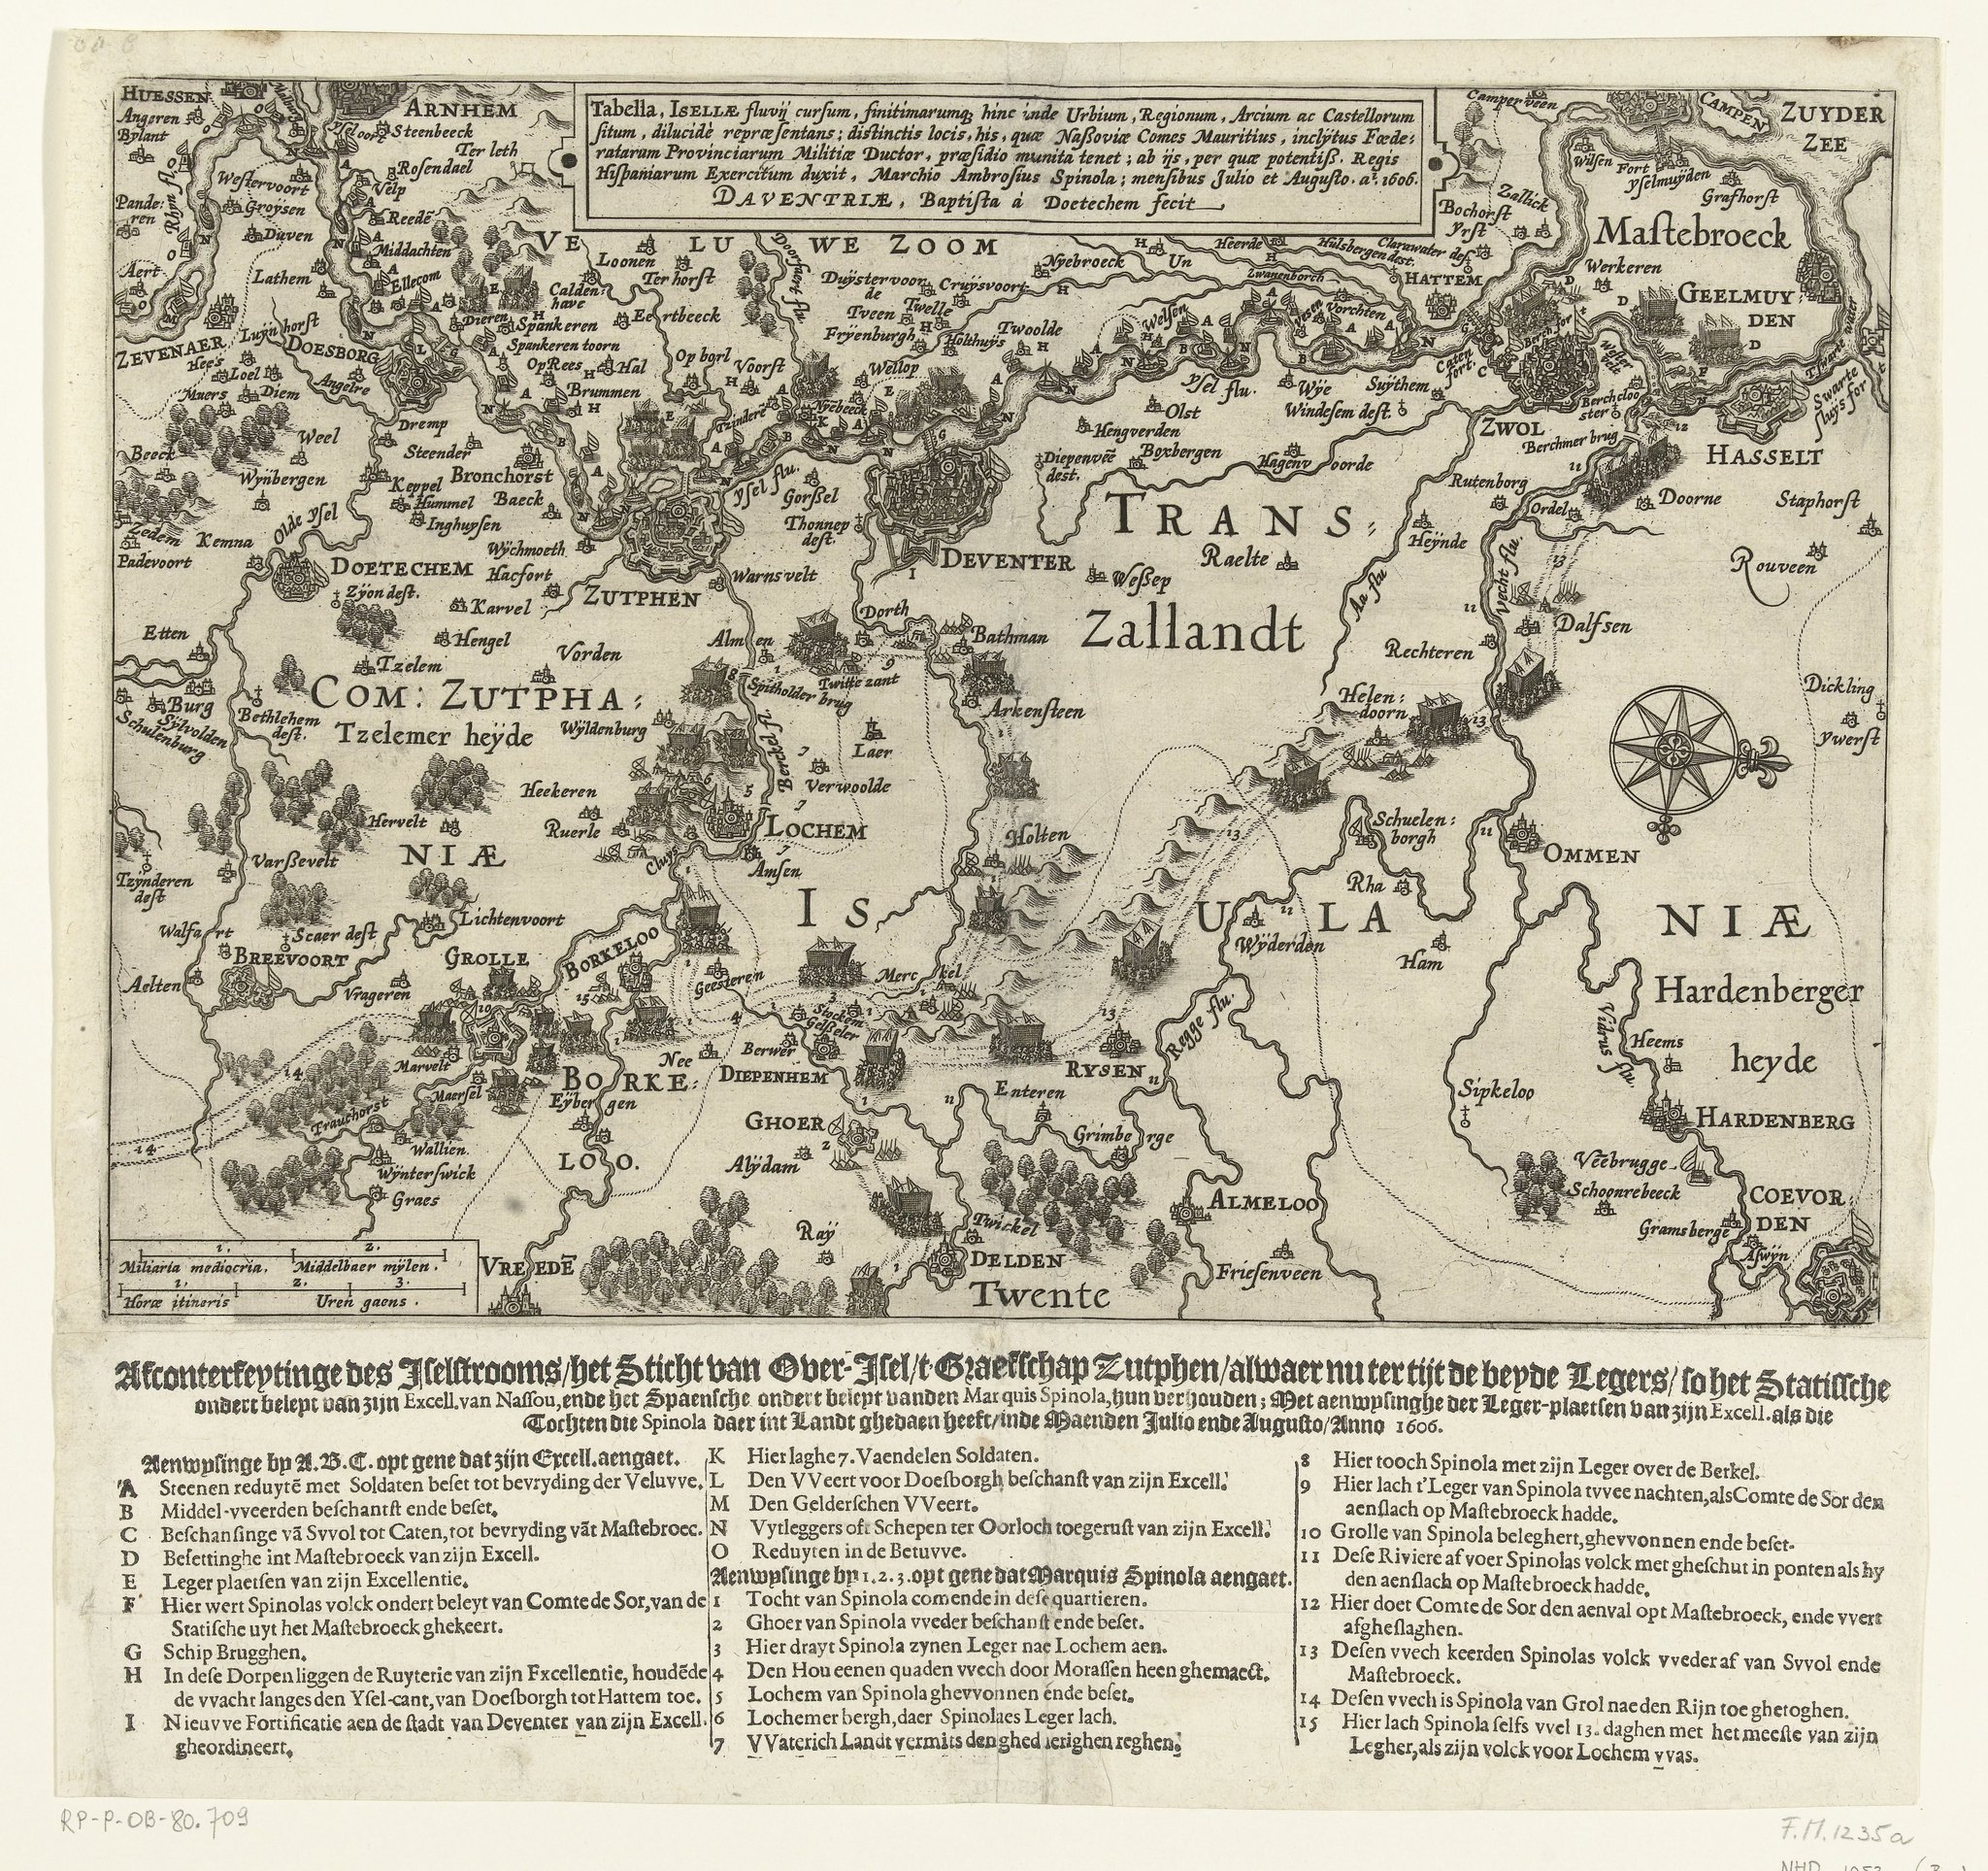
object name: print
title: Afconterfeytinge des Iselstrooms / het Sticht van Over-Isel / t'Graefschap Zutphen / alwaer nu ter tijt de beyde Legers (...) hun verhouden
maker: baptista van doetechum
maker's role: print maker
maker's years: -1611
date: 1606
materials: paper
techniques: engraving, etching, letterpress printing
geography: deventer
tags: the hague, maurice (prince of orange), troop movements, transportation, maps of separate countries or regions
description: De militaire campagnes van het Staatse leger onder prins Maurits en het Spaanse leger onder Spinola in Overijssel en Zutphen, juli-augustus 1606. Kaart van Oost-Nederland van het gebied tussen Arnhem, Groenlo, Coevorden en Zwolle waarop met letters de route van het Staatse leger en met cijfers dat van het Spaanse leger is aangegeven. Bovenaan een cartouche met de Latijnse titel. Onder de prent gedrukt de Nederlandse titel en de legenda's A-O en 1-15.